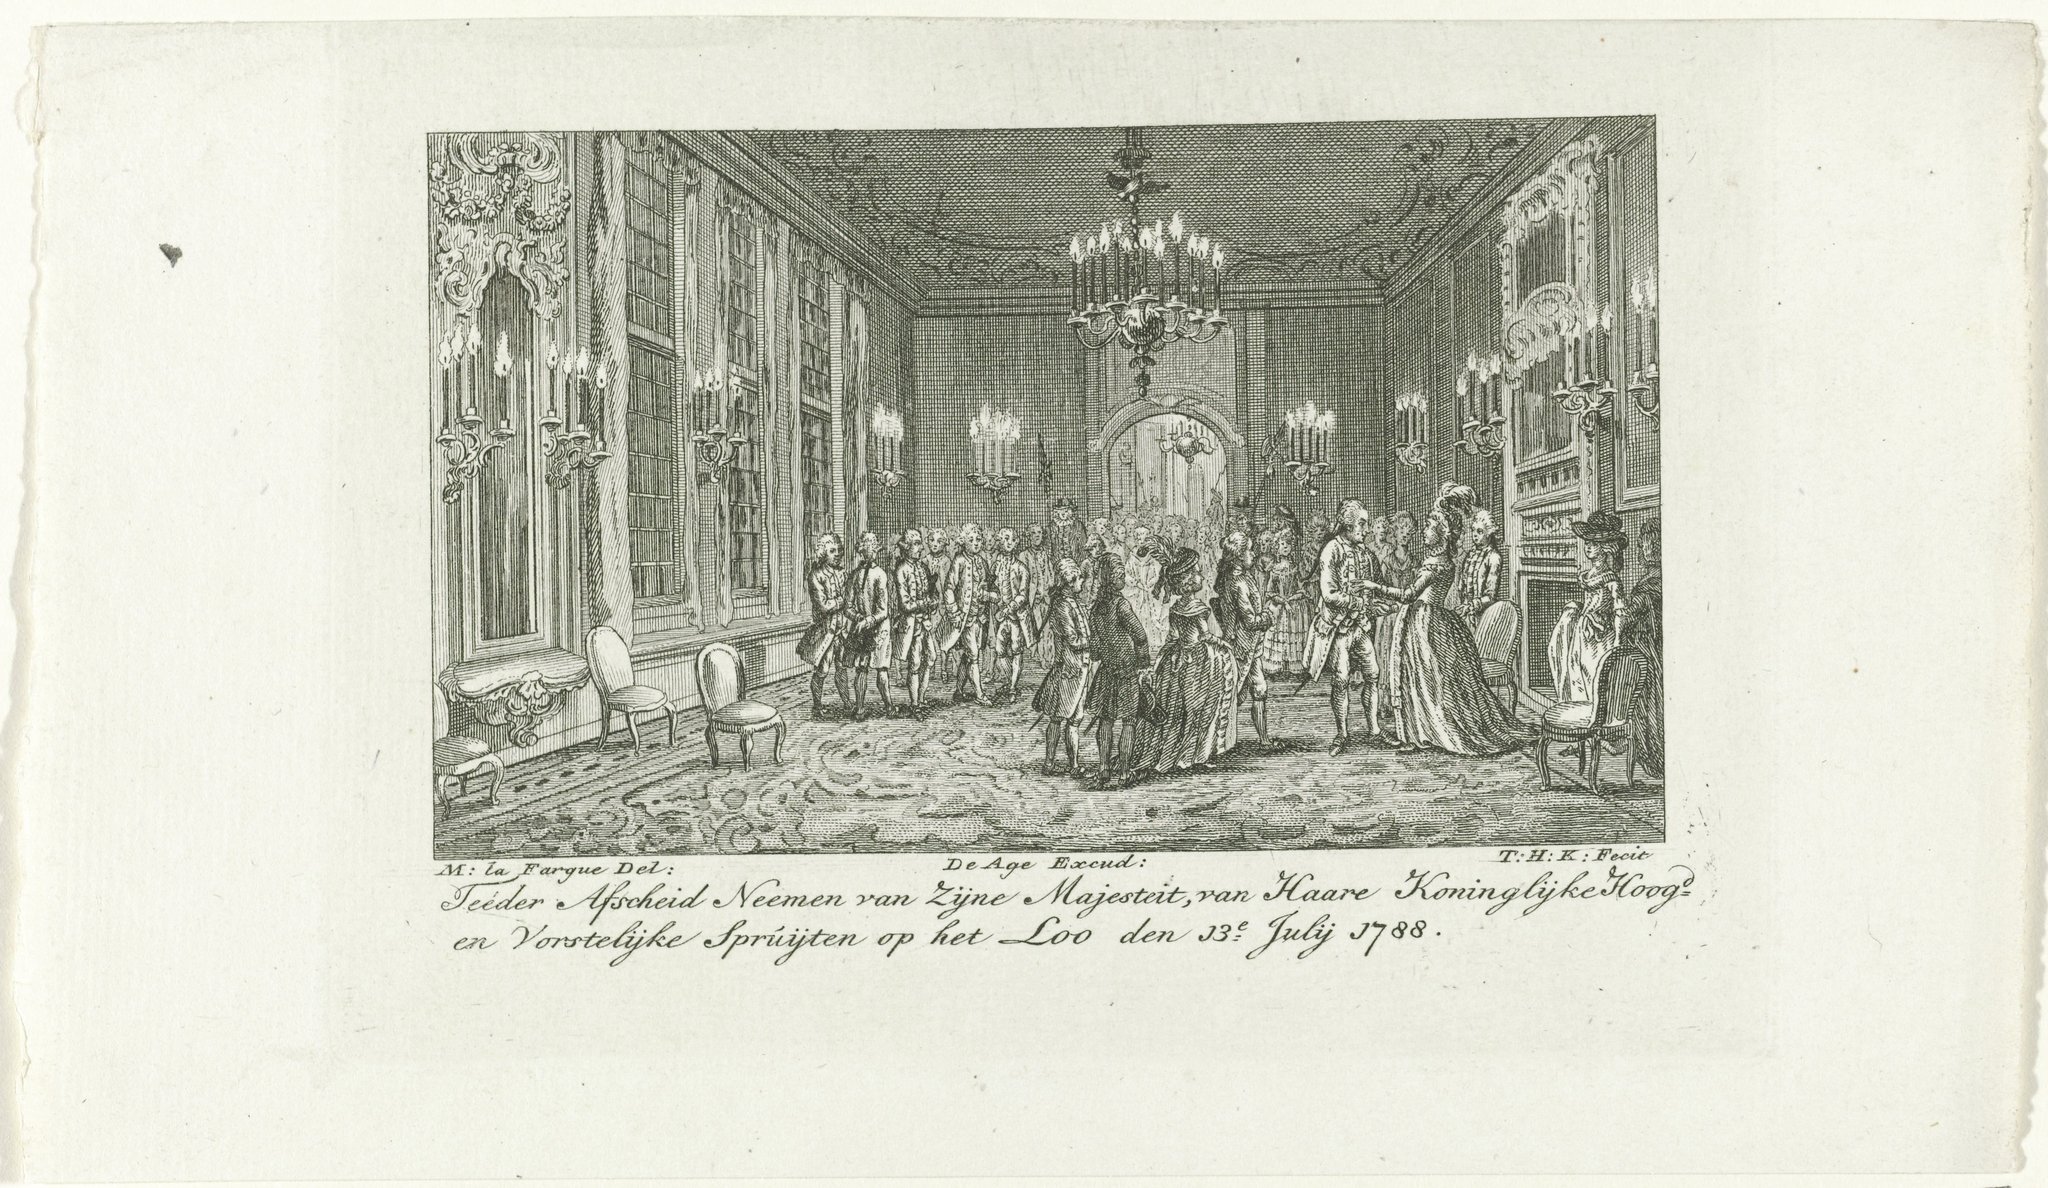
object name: print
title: Teeder Afscheid Neemen van Zijne Majesteit, van Haare Koninglijke Hoog.d en Vorstelijke Spruijten op het Loo den 13e Julij 1788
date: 1788-1789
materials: paper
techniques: etching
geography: northern netherlands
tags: berlin, frederik willem ii (koning van pruisen), painter, draughtsman, wilhelmina of prussia (princess of orange), taking leave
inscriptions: collector's mark: Lugt 2228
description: Koning Frederik Willem II van Pruisen neemt op Paleis Het Loo afscheid van zijn zuster en haar kinderen, 13 juli 1788.